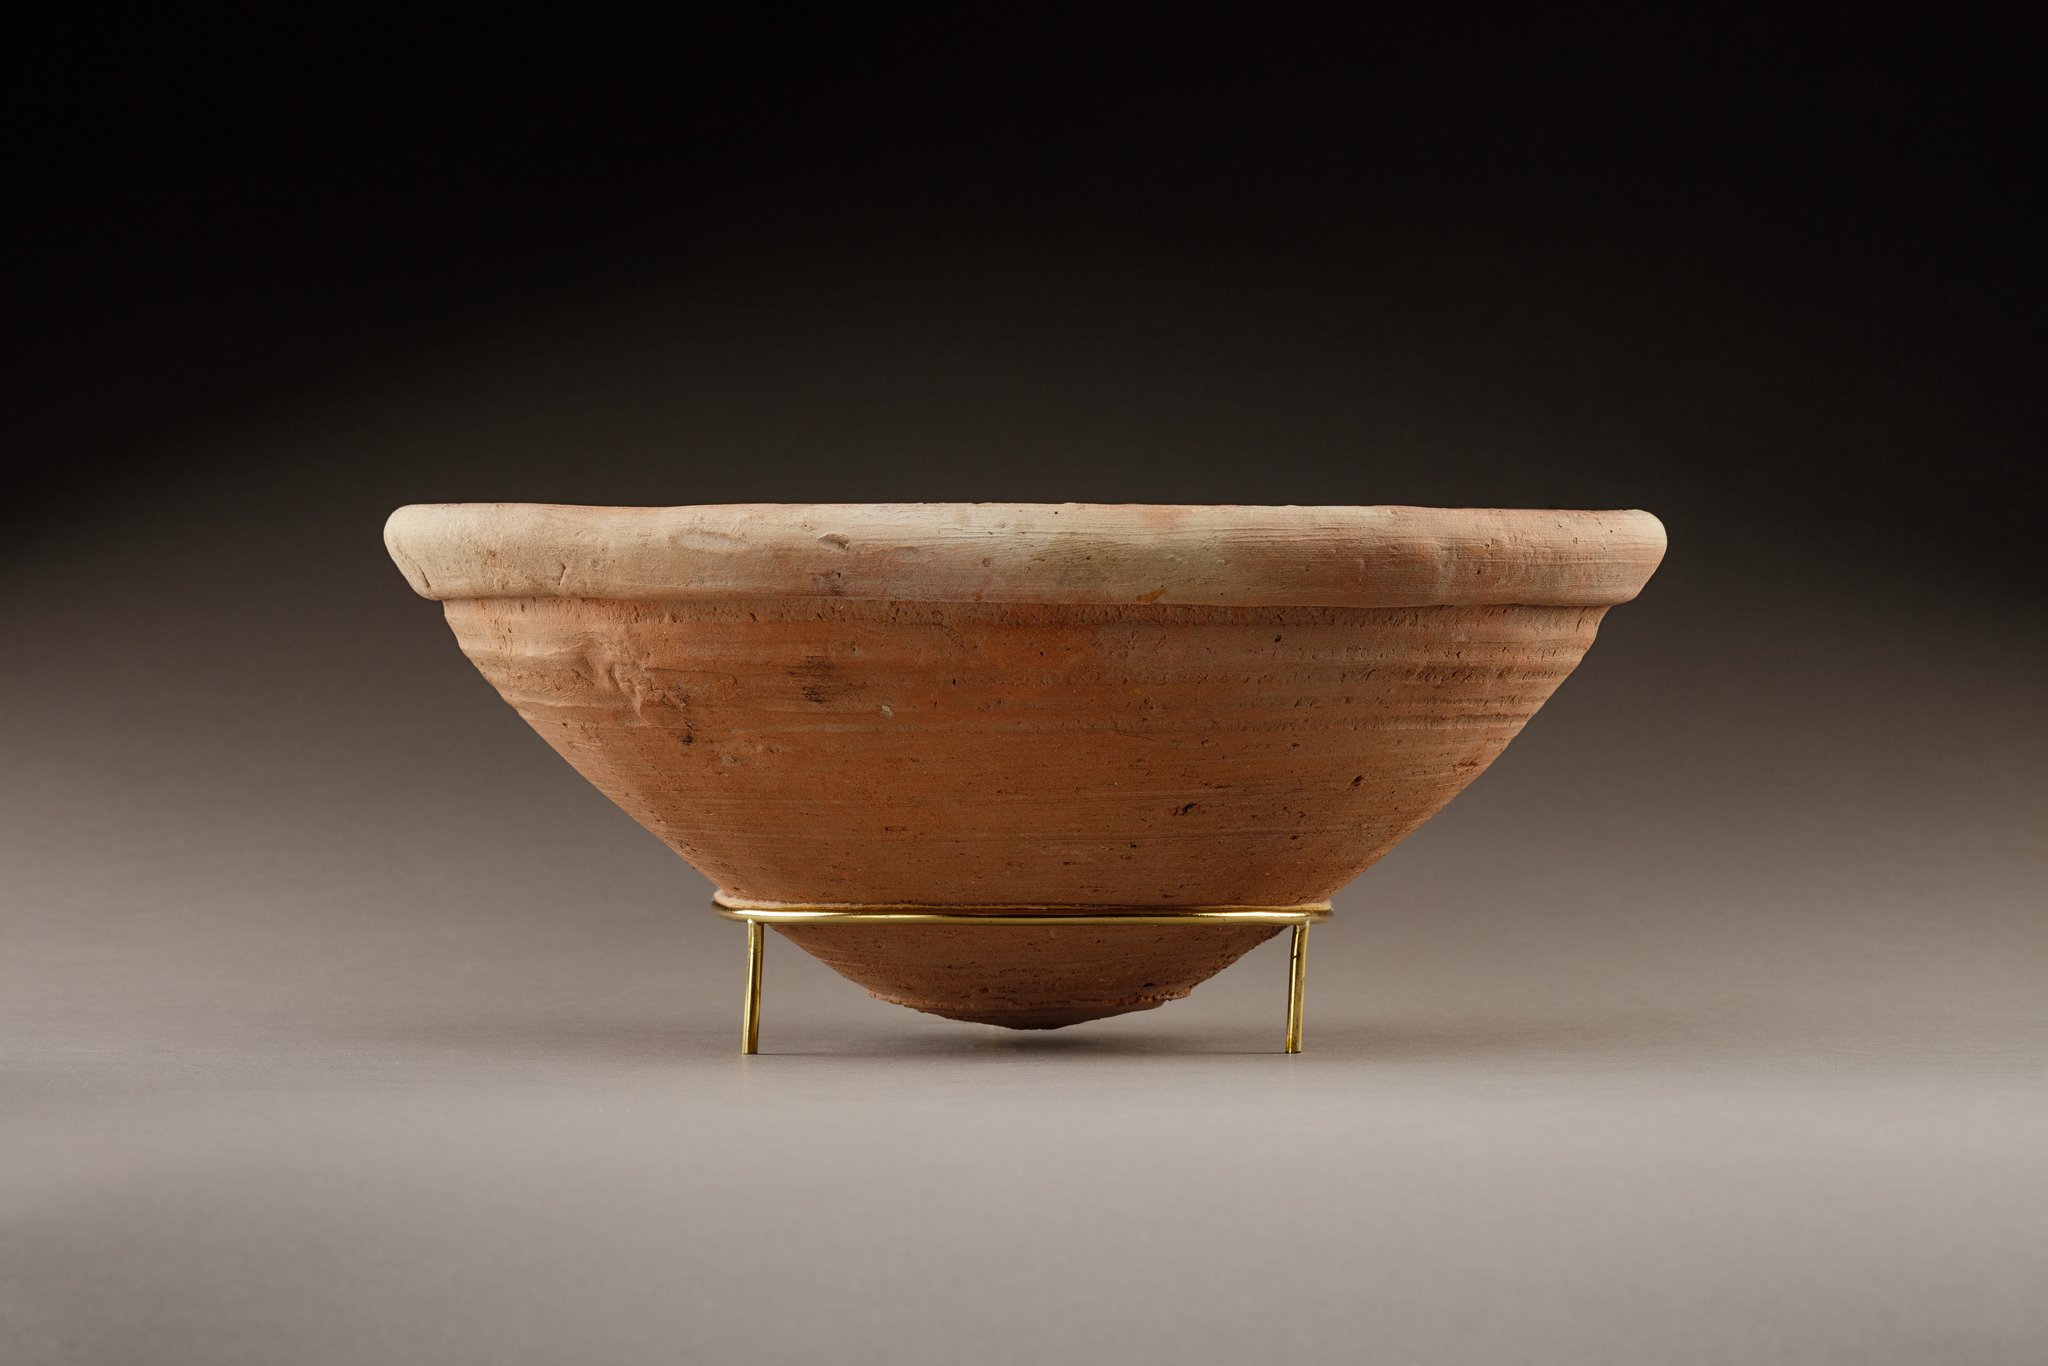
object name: bowl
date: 664-332 BCE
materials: pottery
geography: egypt